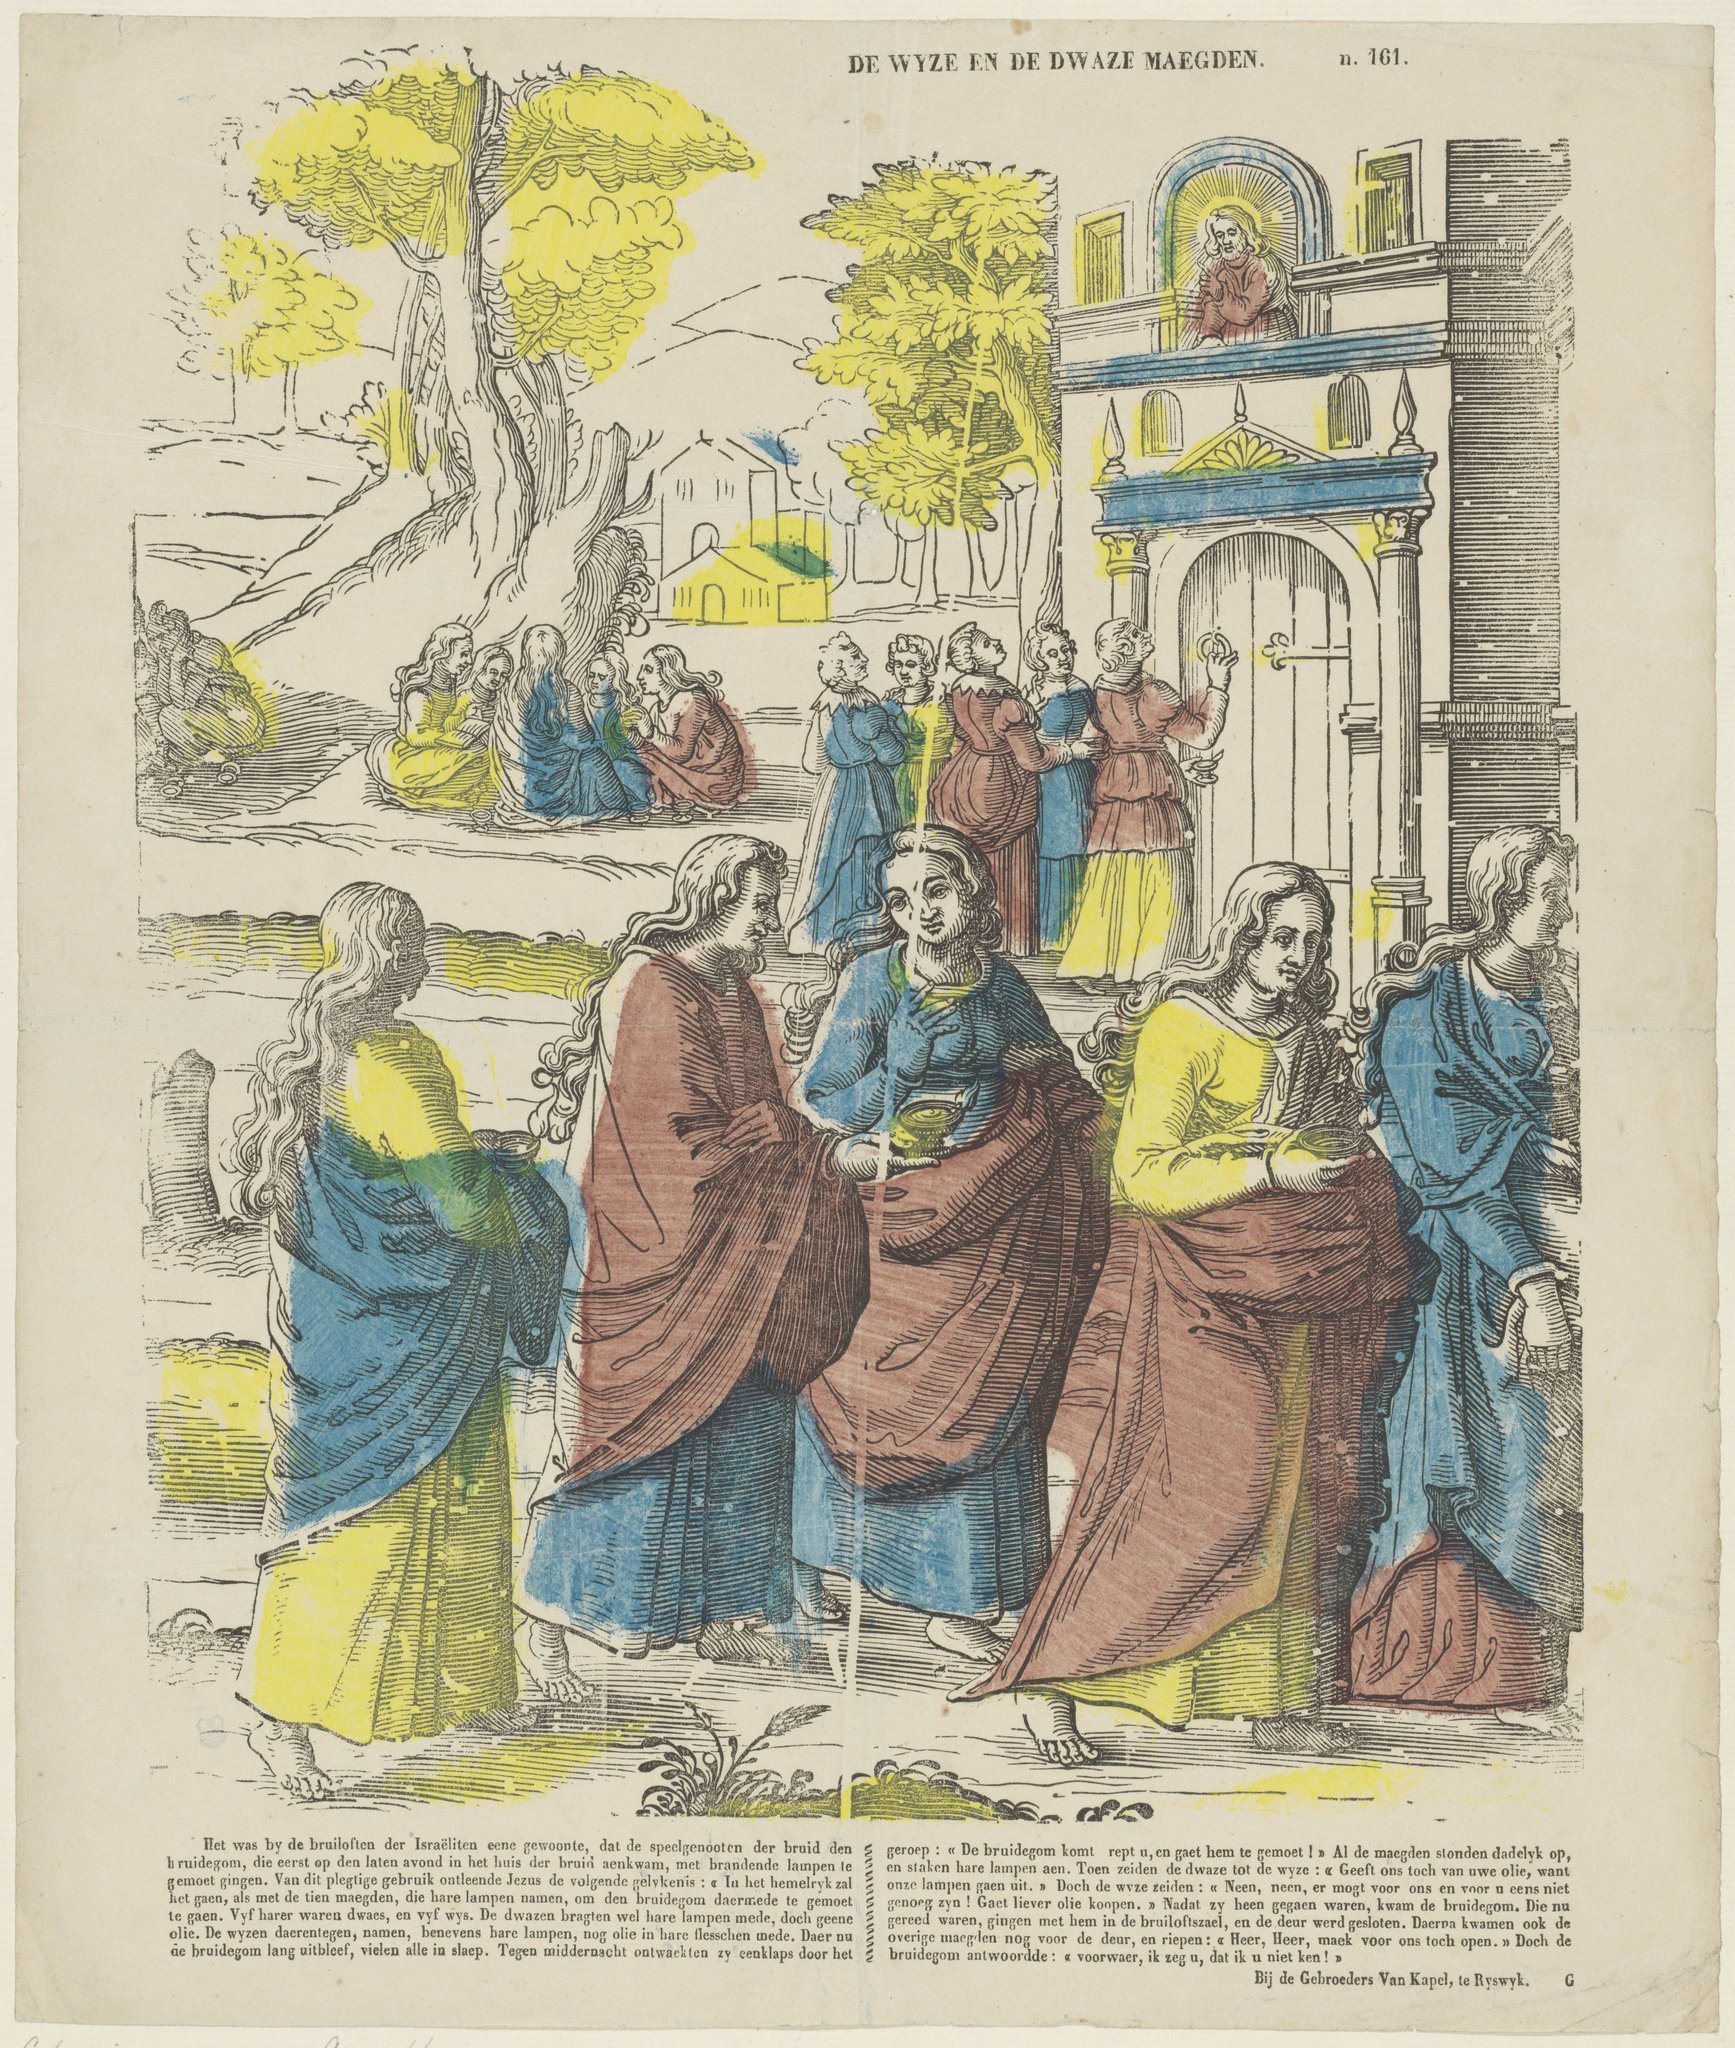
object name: popular print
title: De wyze en de dwaze maegden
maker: Anonymous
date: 1833-1856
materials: paper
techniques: colour, letterpress printing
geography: rijswijk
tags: the wise and the foolish virgins ~ parable of christ (matthew 25:1-13)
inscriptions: collector's mark: Lugt 2760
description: Blad met een grote voorstelling van de parabel van de wijze en de dwaze maagden. In de ondermarge een onderschrift in twee kolommen. Genummerd rechtsboven: n. 161.